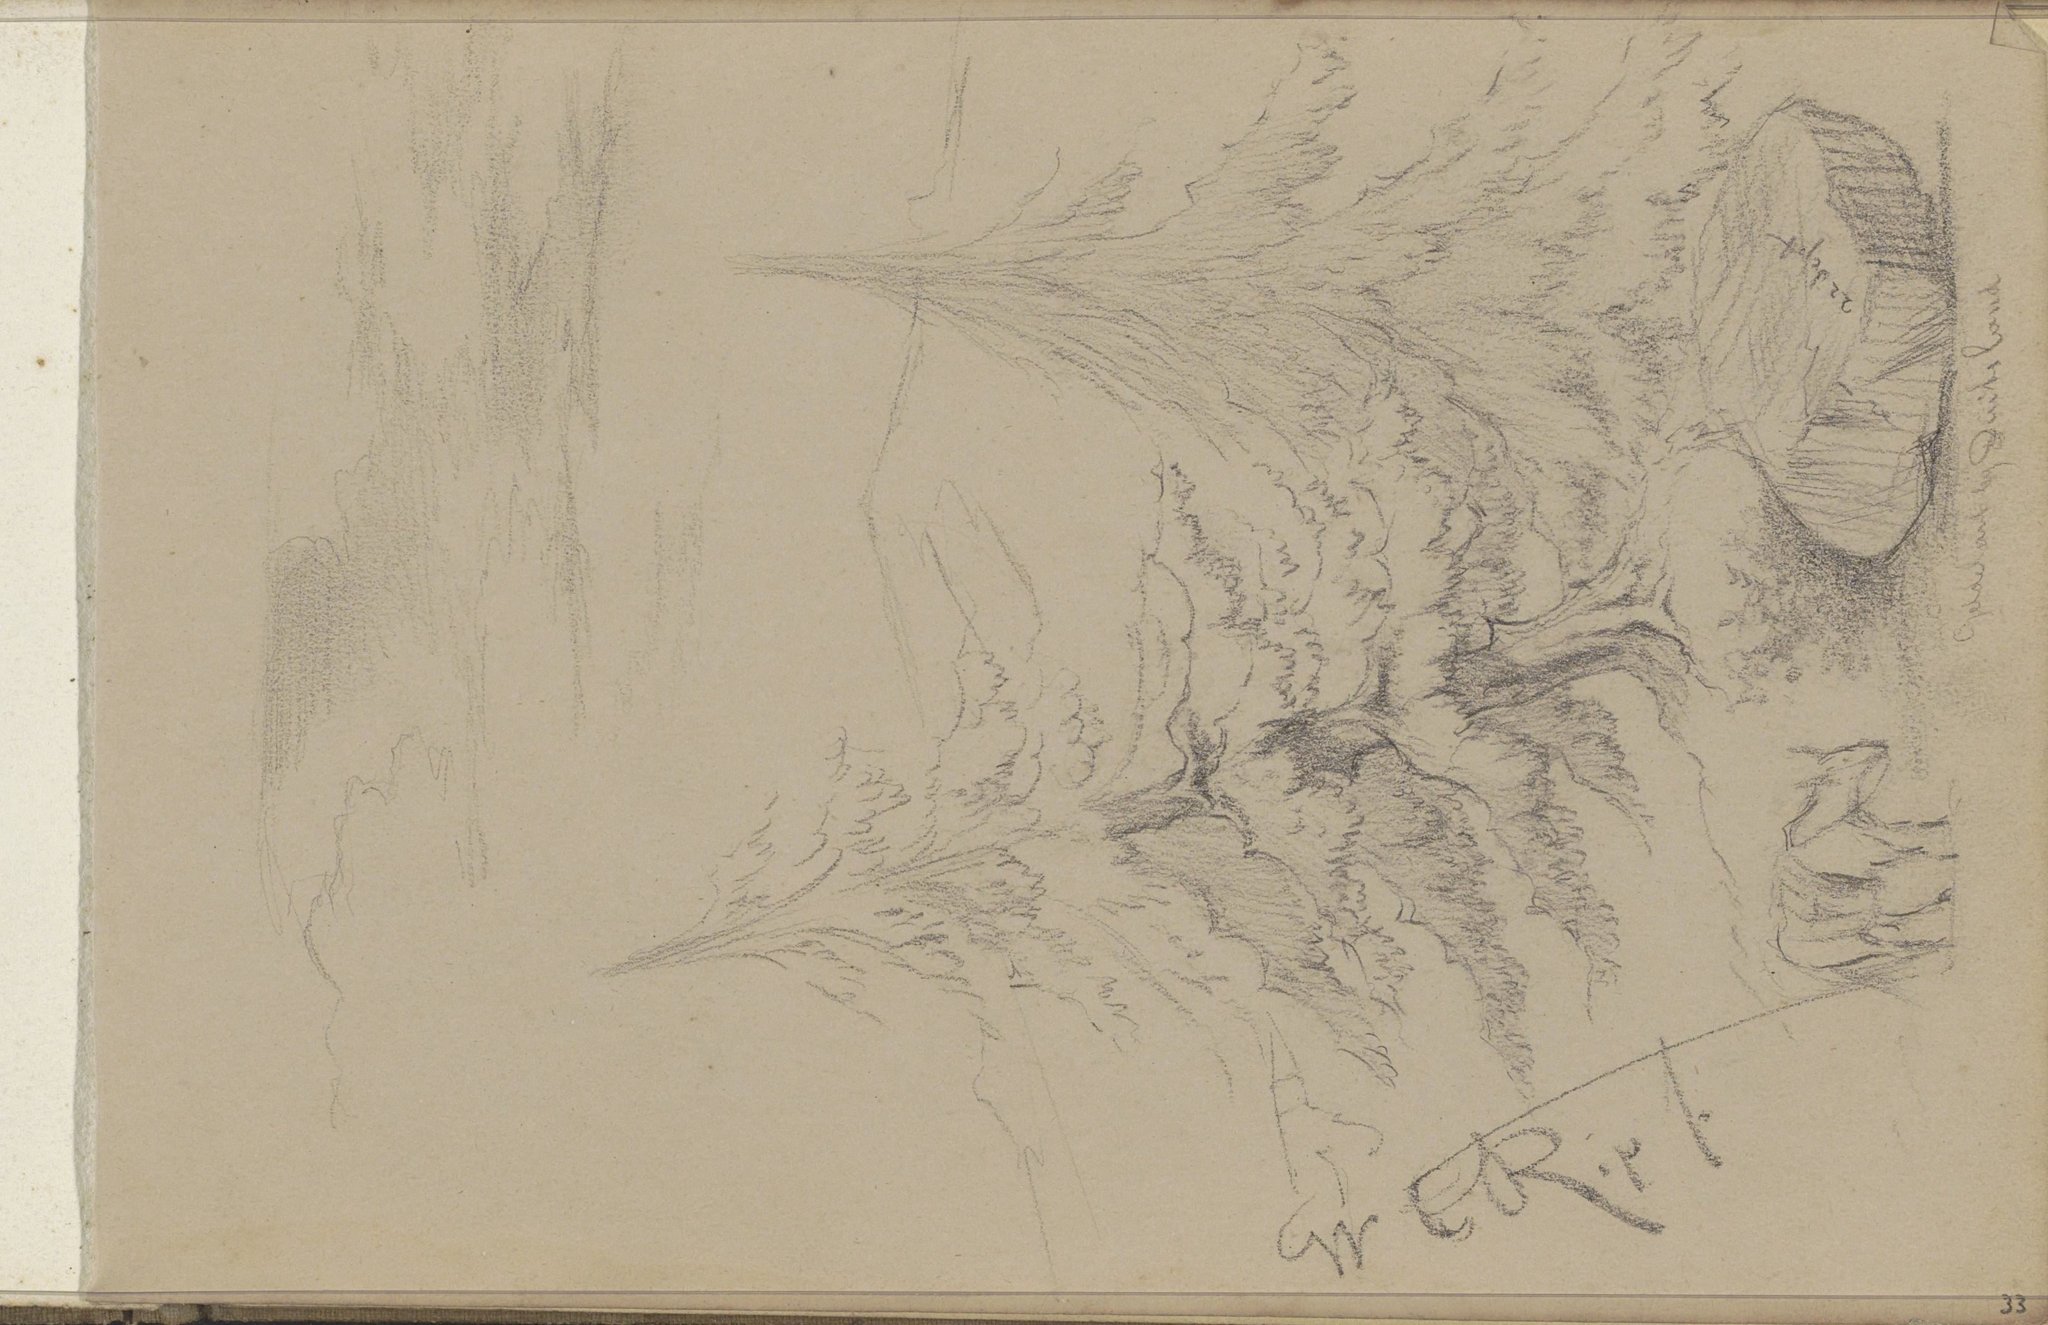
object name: sketchbook leaf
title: Naaldbomen bij de grens van Gelderland met Duitsland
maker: willem cornelis rip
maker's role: draughtsman, painter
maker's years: 1856-1922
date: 1809-1874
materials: paper, pencil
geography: gelderland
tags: trees, boulder, stone, gelderland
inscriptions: signature: ‘WC Rip f.’, date and inscription: ‘22 sept/ Gelderland bij Duitsland’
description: Blad 33 recto uit een schetsboek met 47 bladen.